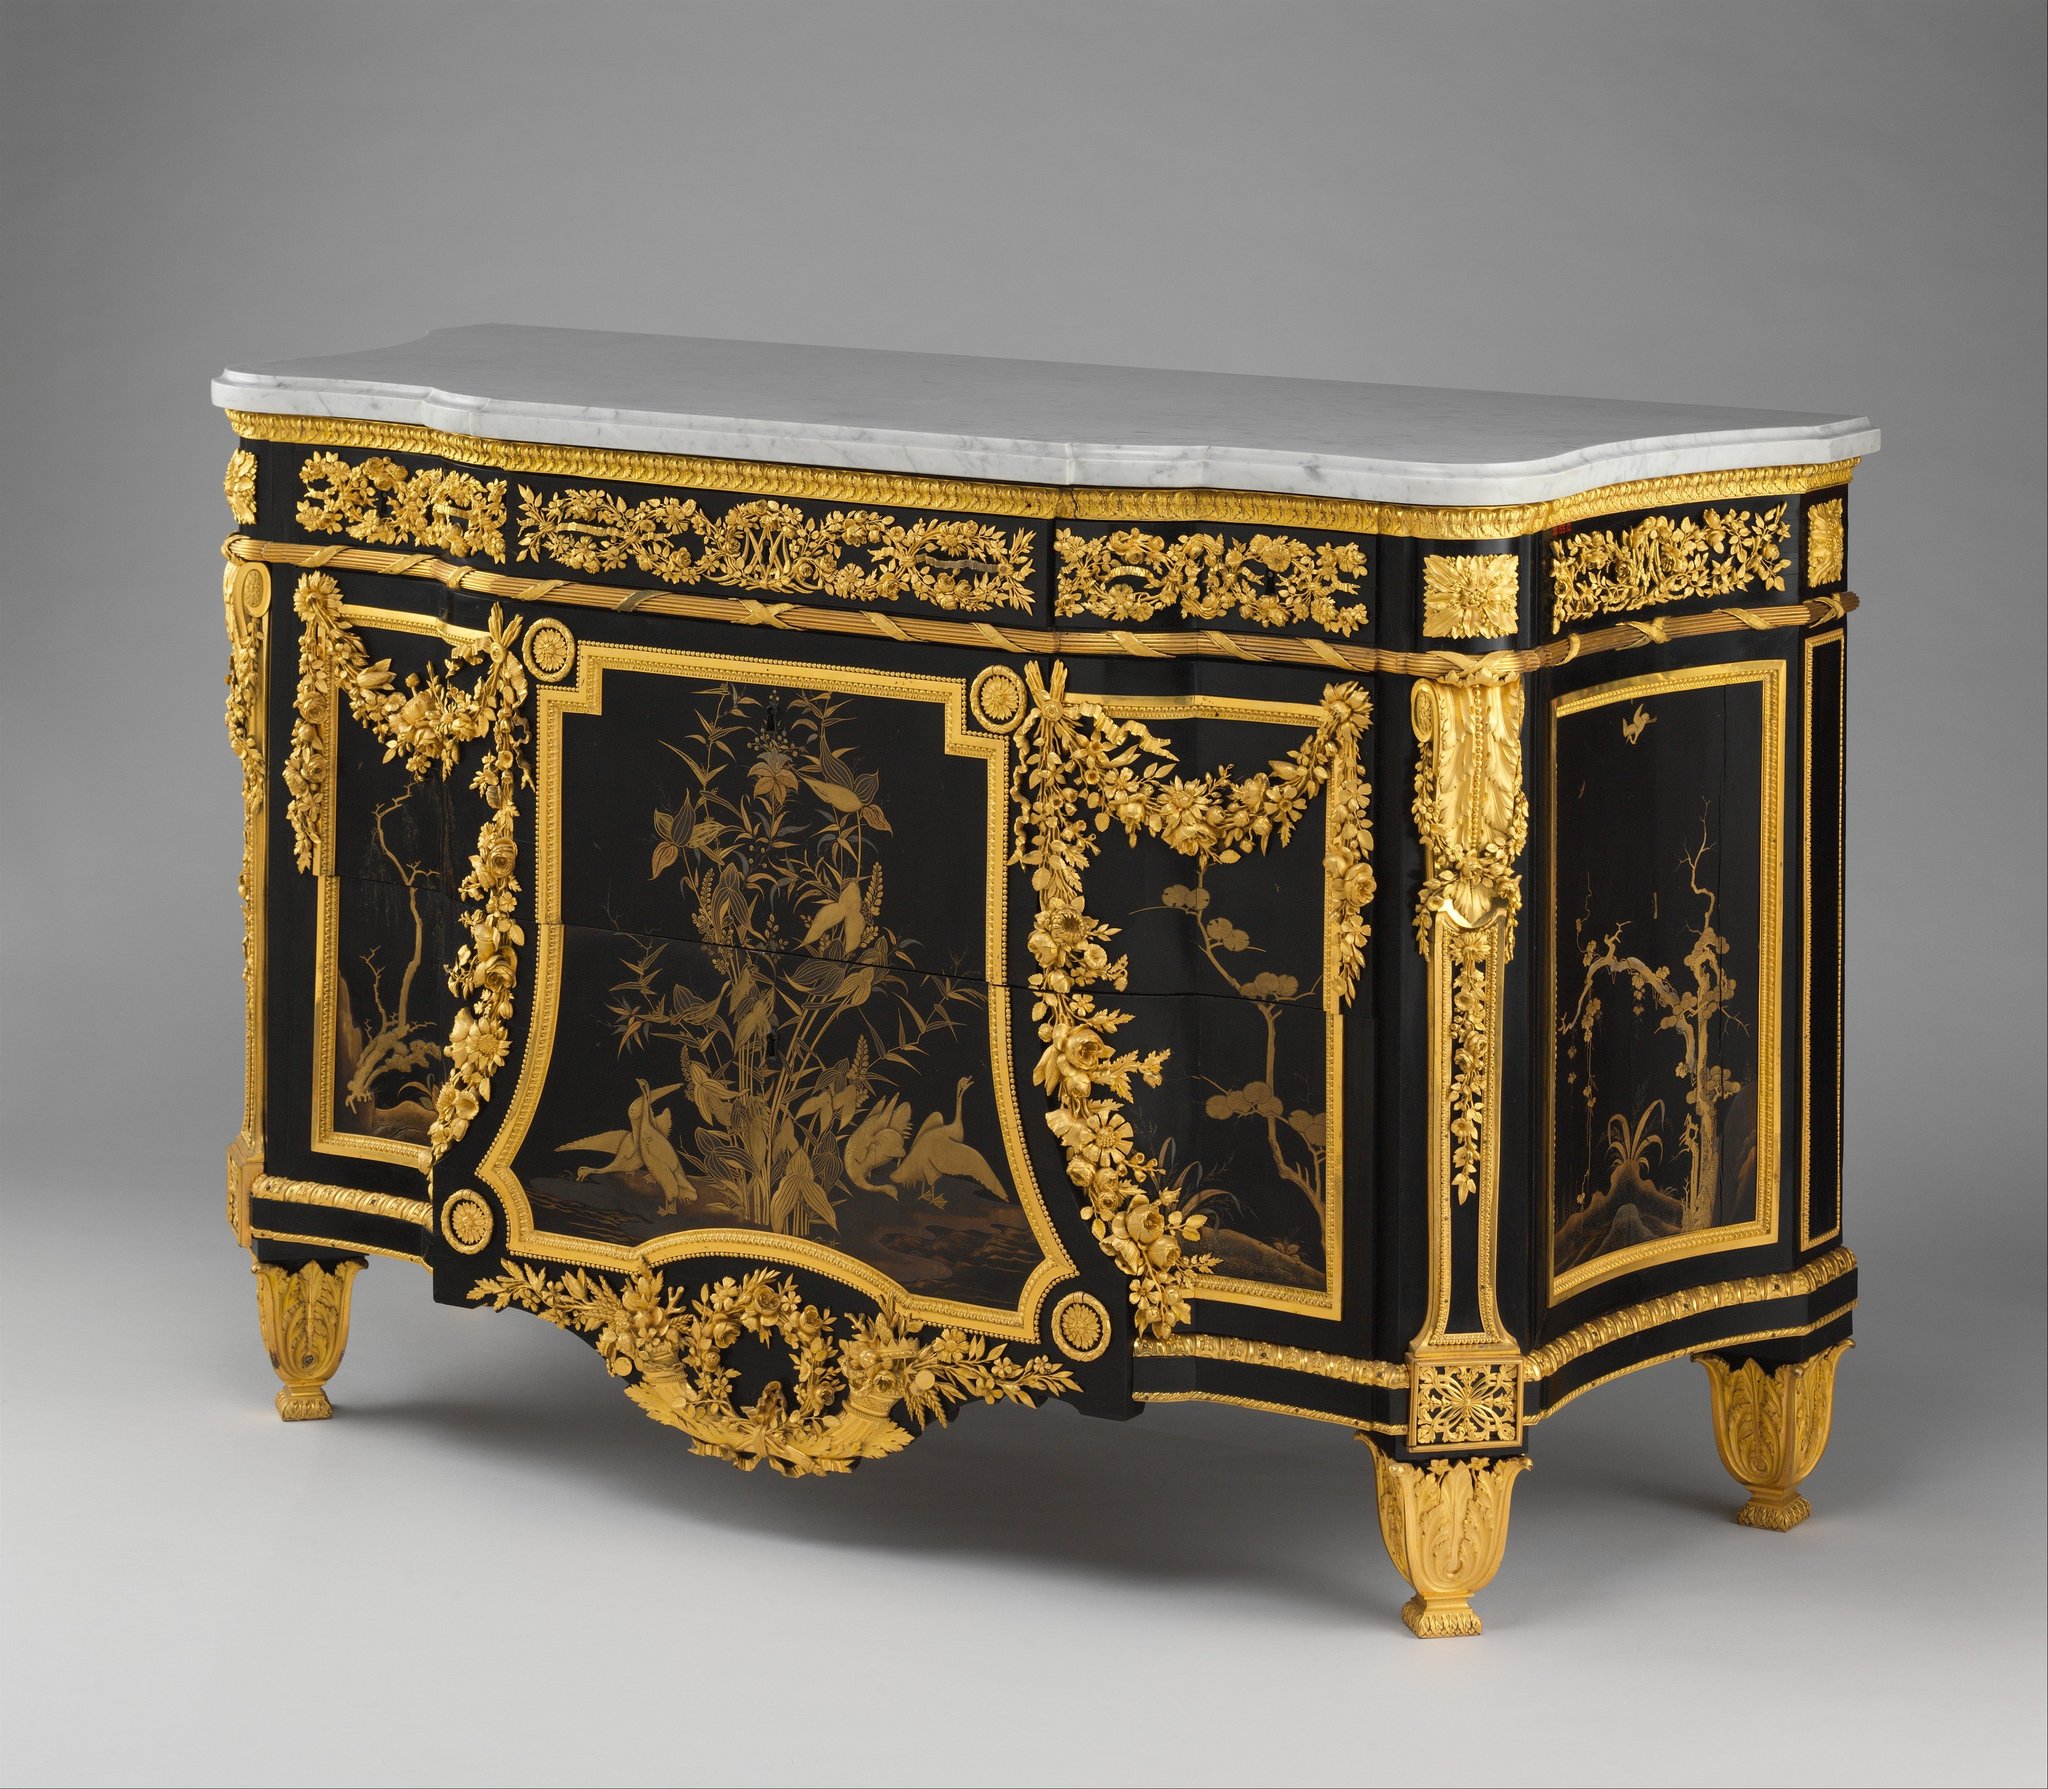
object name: commode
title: Commode (Secrétaire à abattant)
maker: jean henri riesener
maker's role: maker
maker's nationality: french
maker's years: 1734-1806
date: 1783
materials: wood, gilt bronze, lacquer, marble, velvet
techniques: veneering